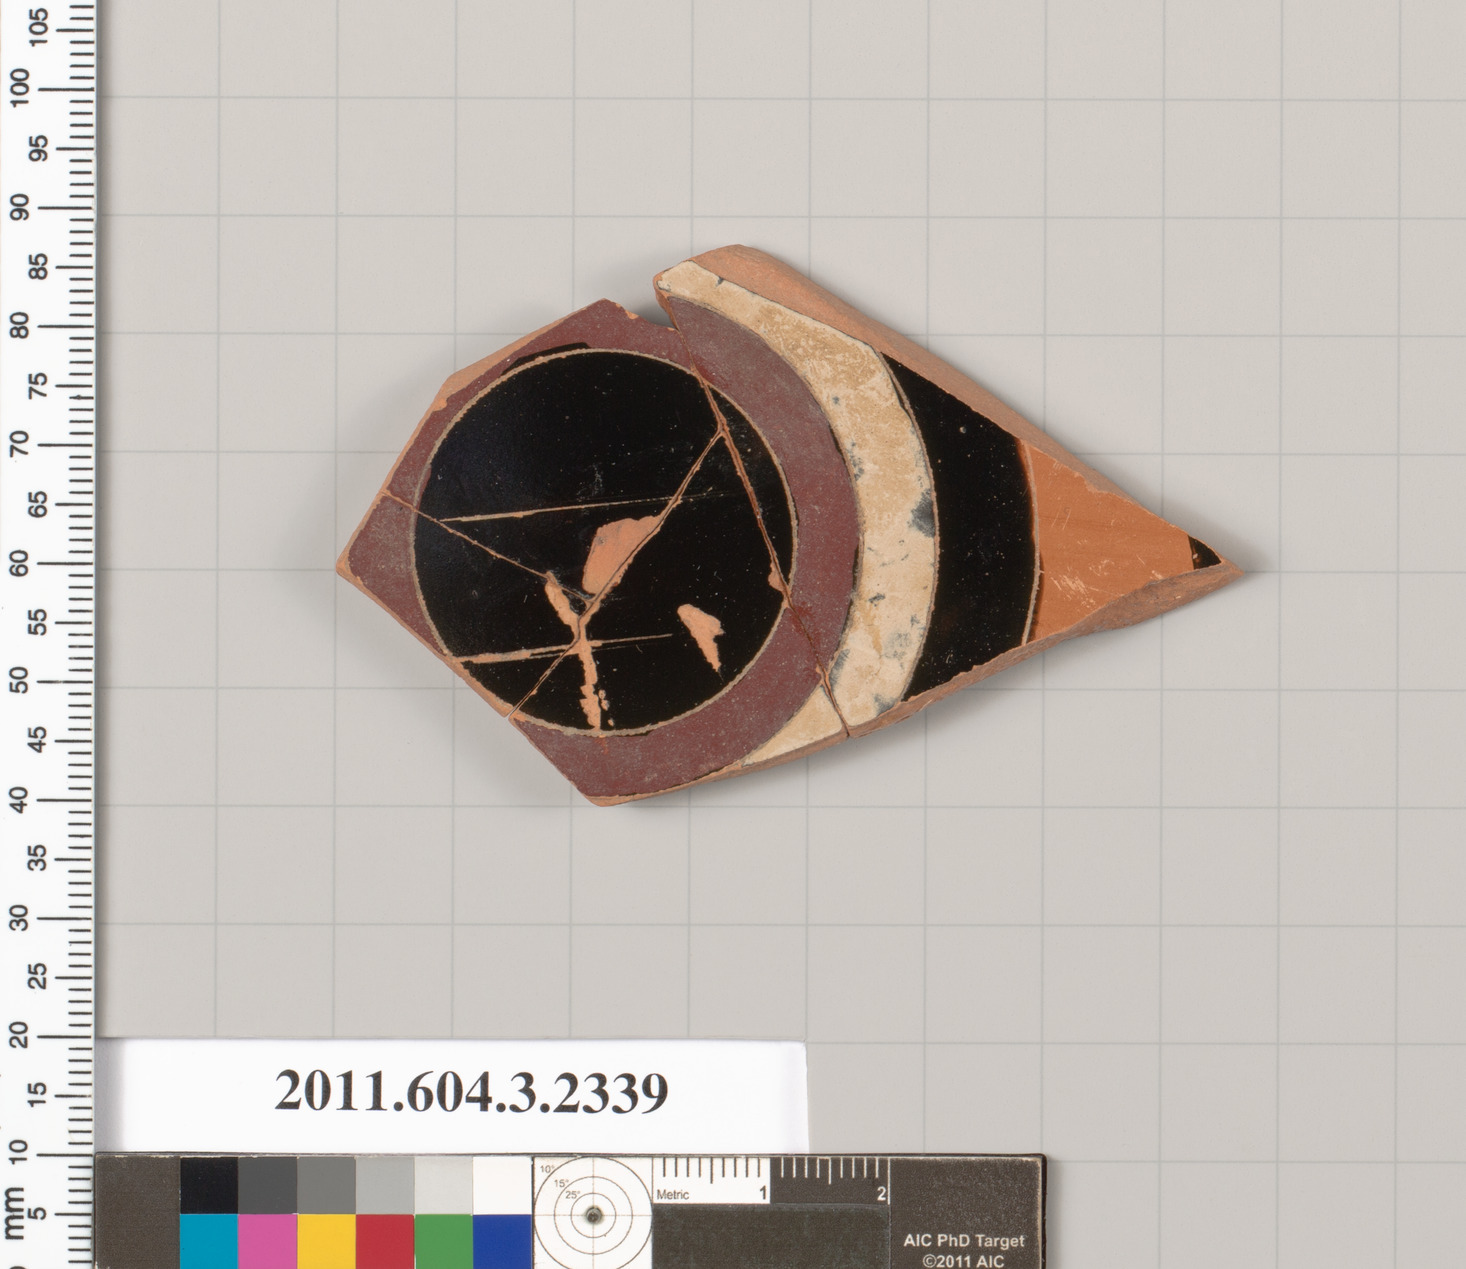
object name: kylix fragment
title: Terracotta fragment of a kylix: eye-cup (drinking cup)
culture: greek, attic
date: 540-520 BCE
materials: terracotta